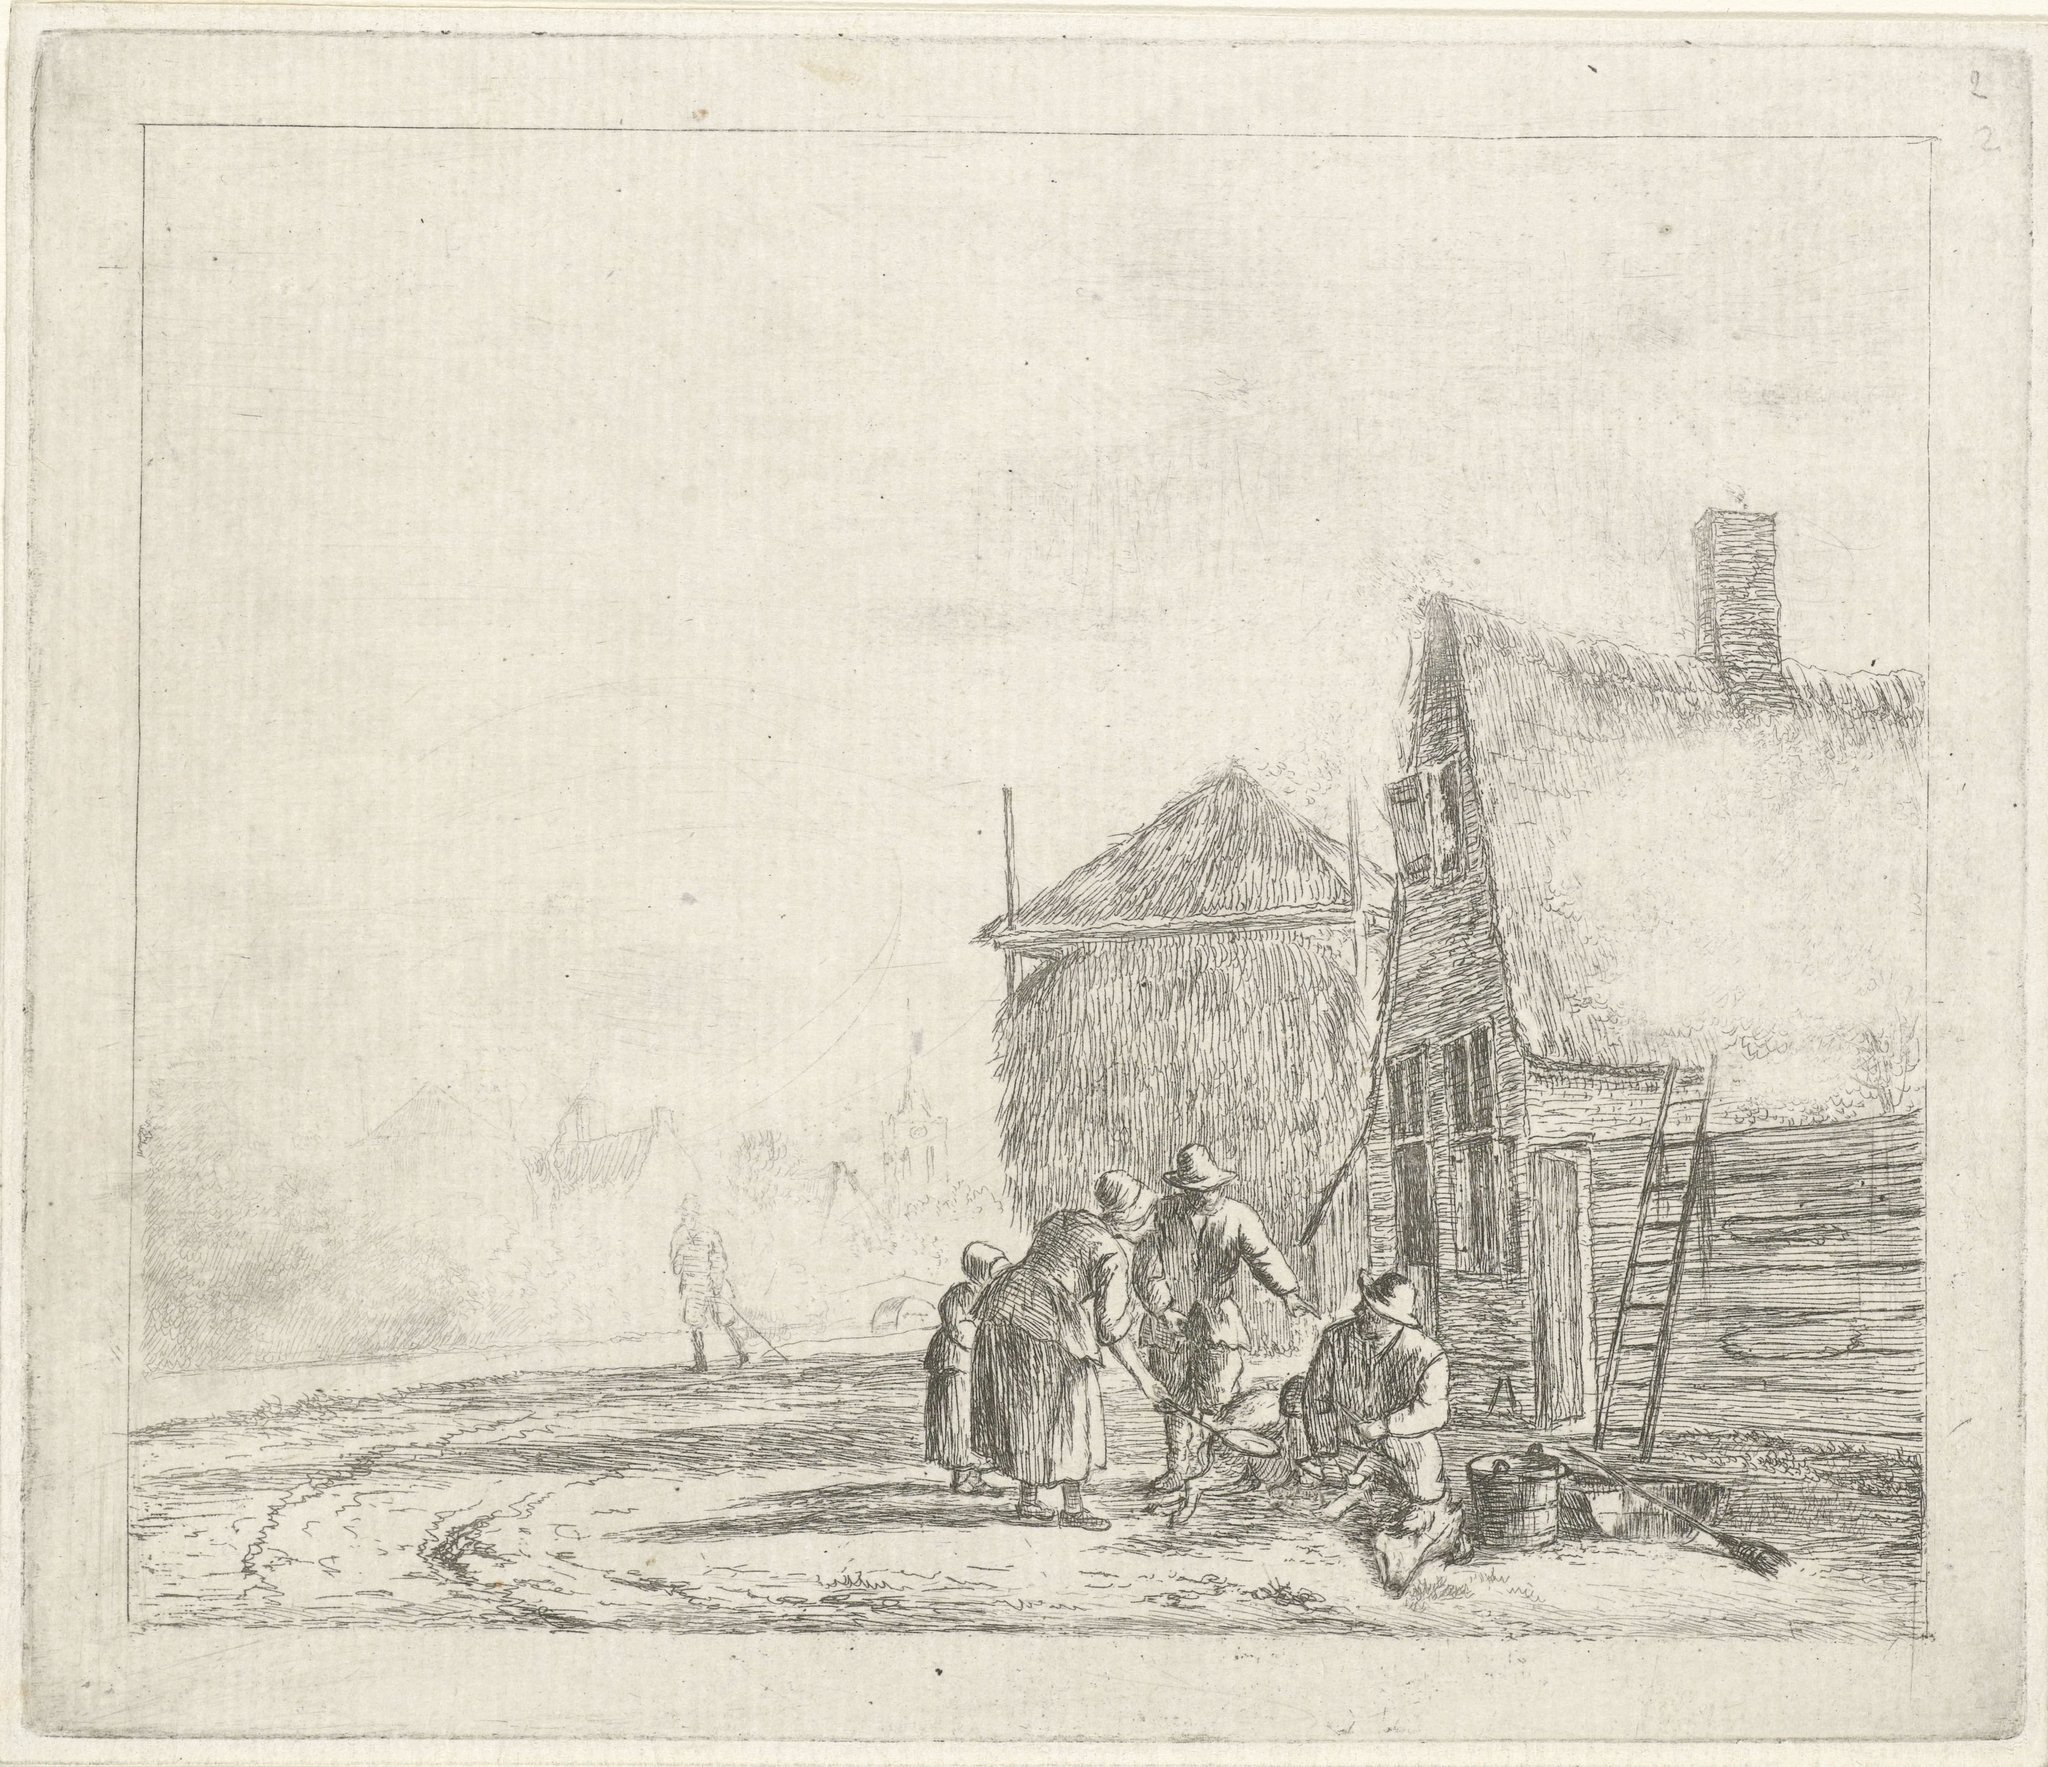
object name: print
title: November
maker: johannes janson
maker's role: draughtsman, painter, print maker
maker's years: 1729-1784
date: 1783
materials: paper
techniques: etching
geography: leiden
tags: landscape symbolizing november, hay-stack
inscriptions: collector's mark: Lugt 2228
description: Landschap met rechts een boerderij en een hooischuur. Voor de boerderij een groep van twee vrouwen en twee mannen, van wie één een varken open snijdt. Bomen bij de boerderij en hooischuur en de achtergrond zijn uitgeslepen. Links op een pad een wandelende man. Vóór de lucht. Twaalfde prent uit een serie van dertien met maanden.